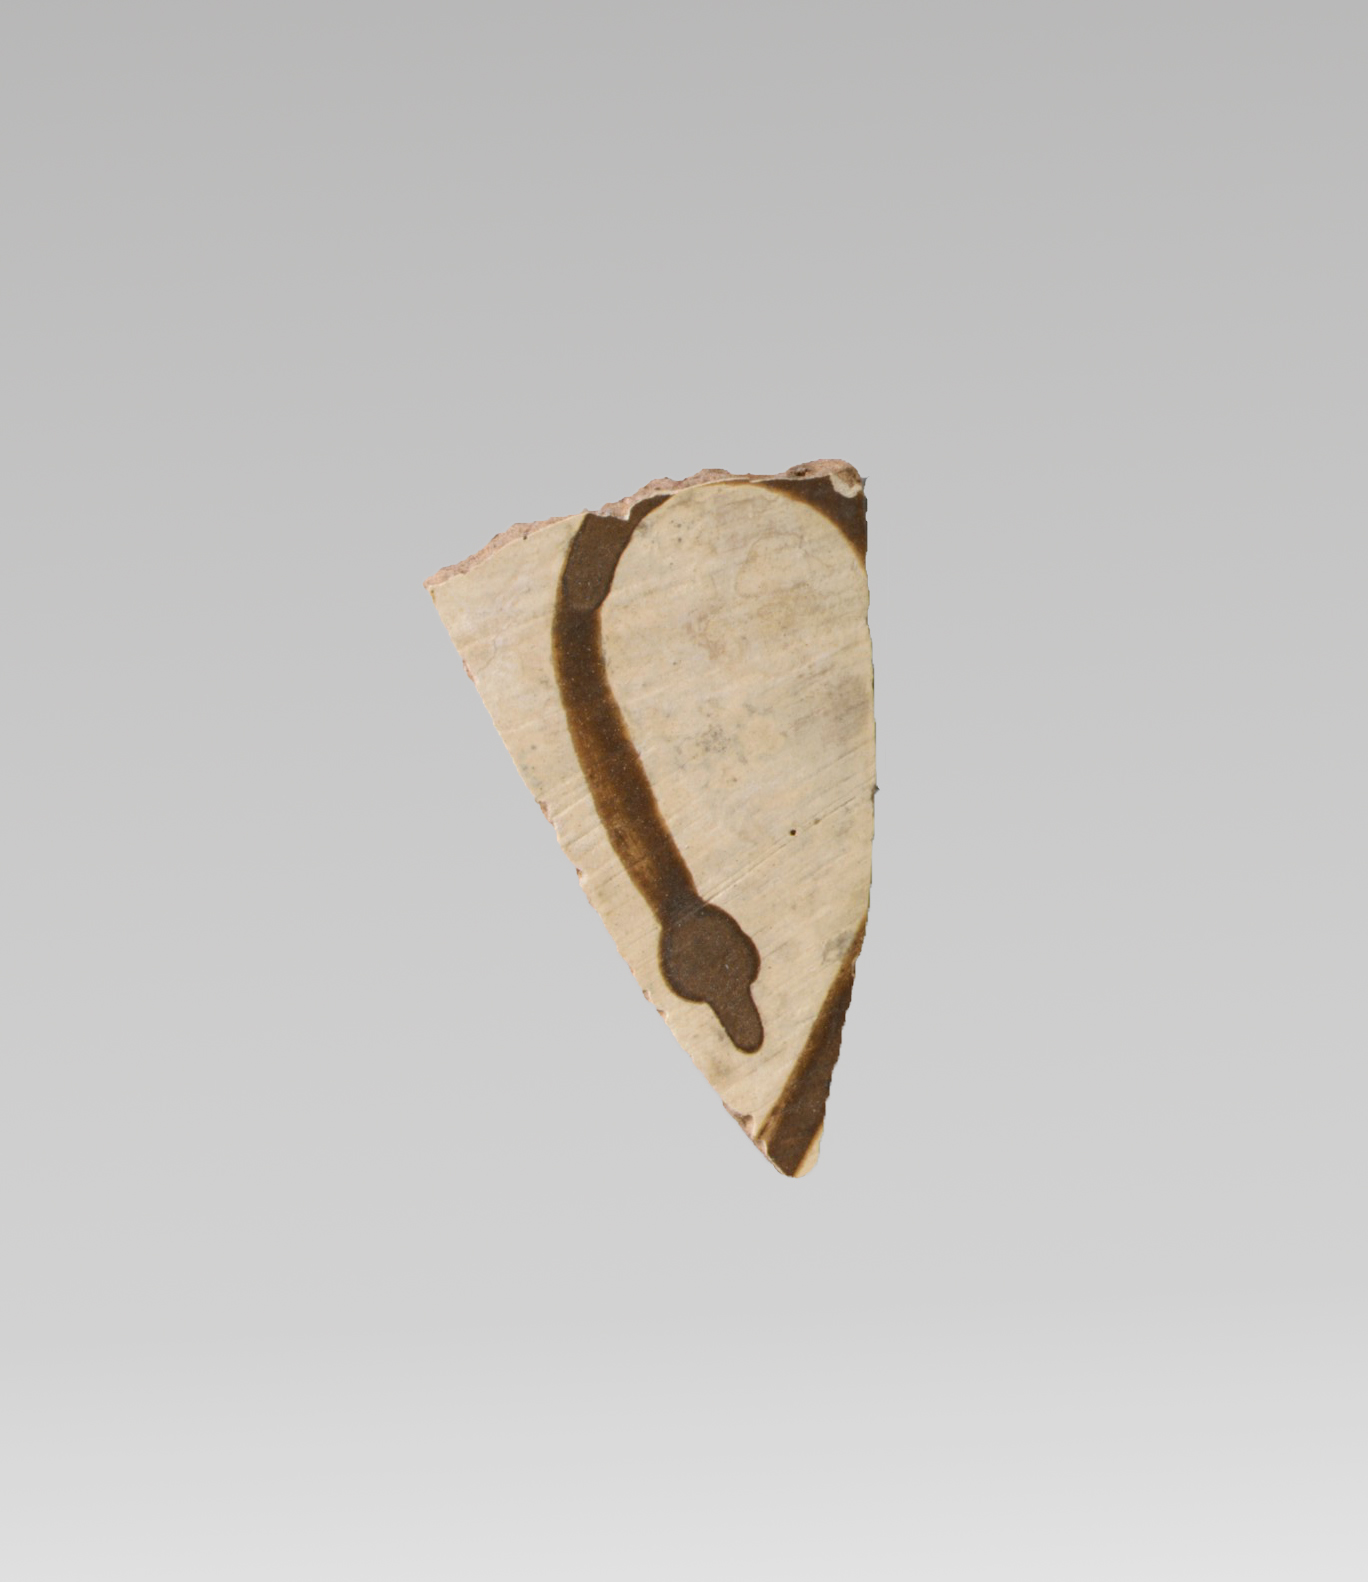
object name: vase fragment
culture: east greek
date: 700-601 BCE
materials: terracotta